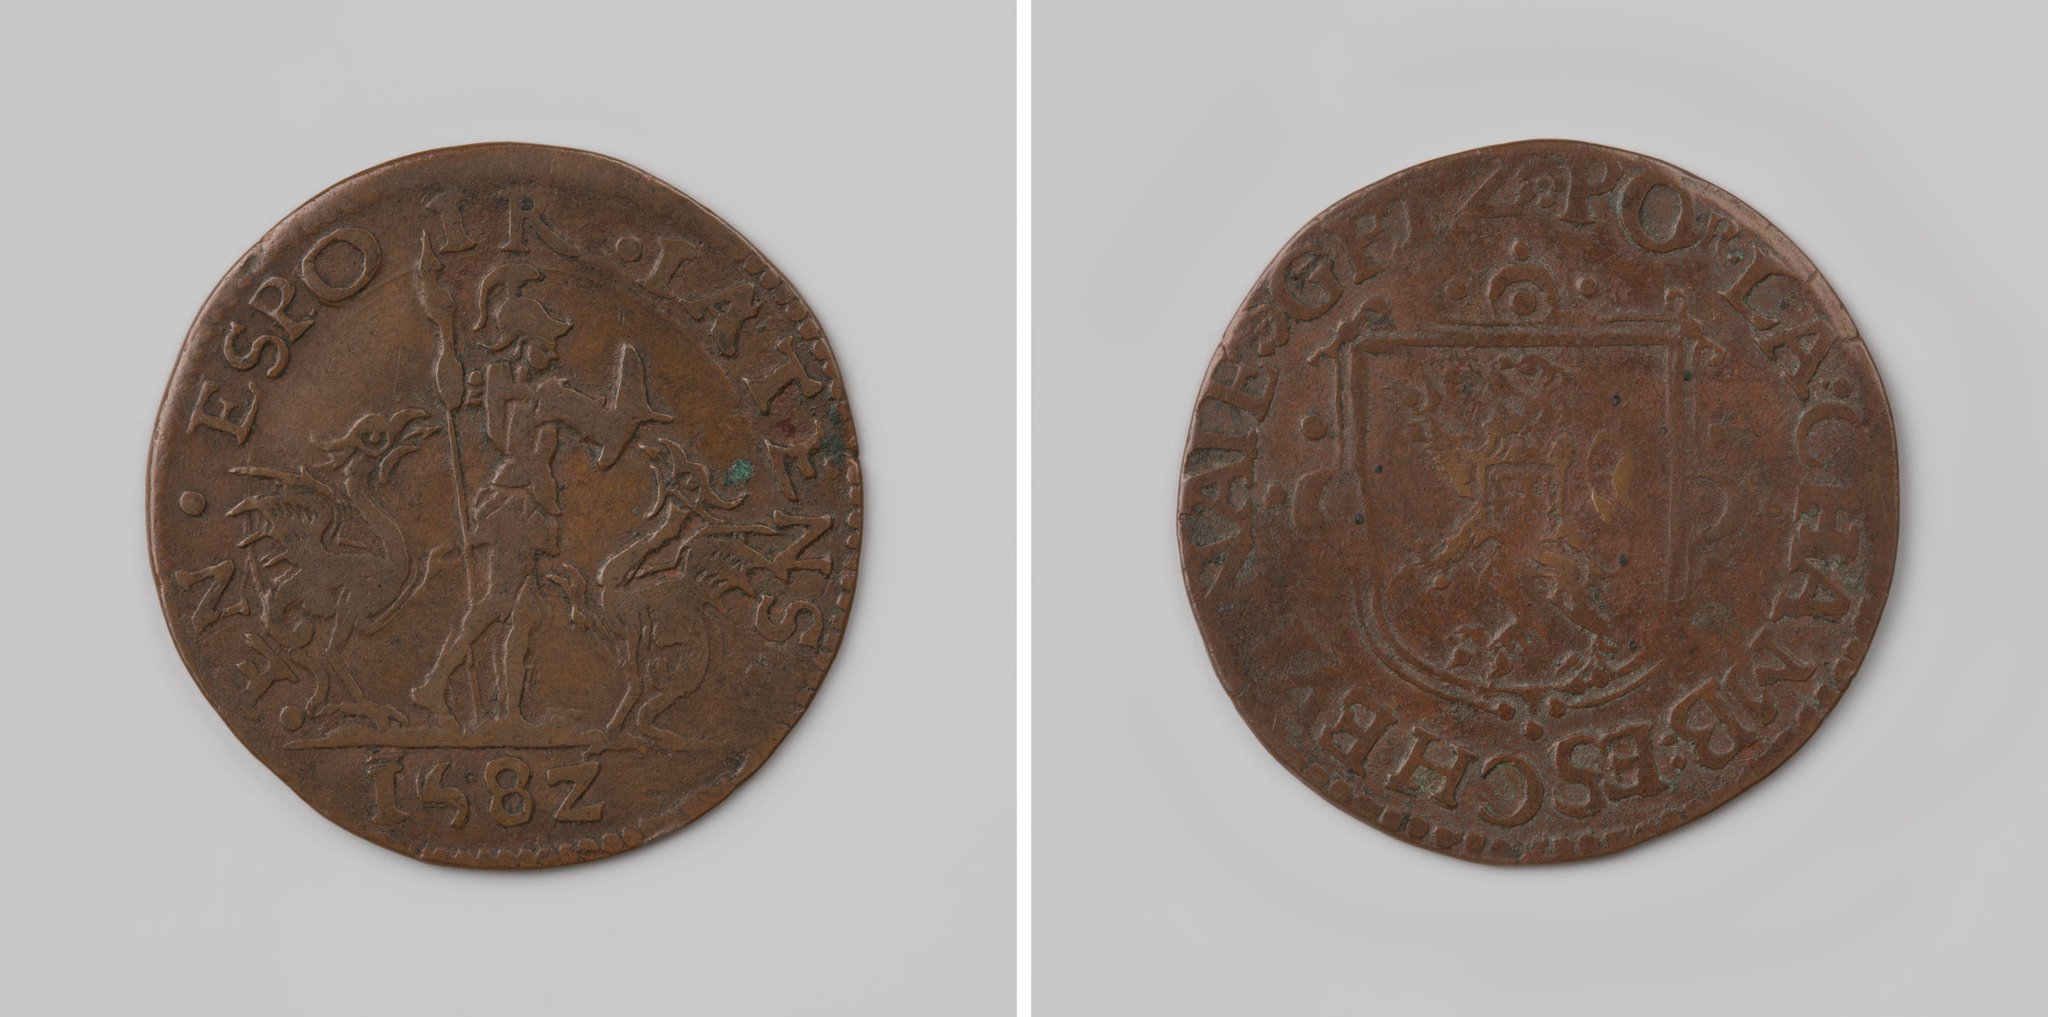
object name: jeton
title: Schepenkamer van Atrecht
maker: Anonymous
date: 1582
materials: copper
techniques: striking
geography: arras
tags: arras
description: Koperen penning. Voorzijde: gehelmde soldaat met lans en schild, staande temidden van twee draken binnen omschrift. Keerzijde: wapenschild binnen omschrift